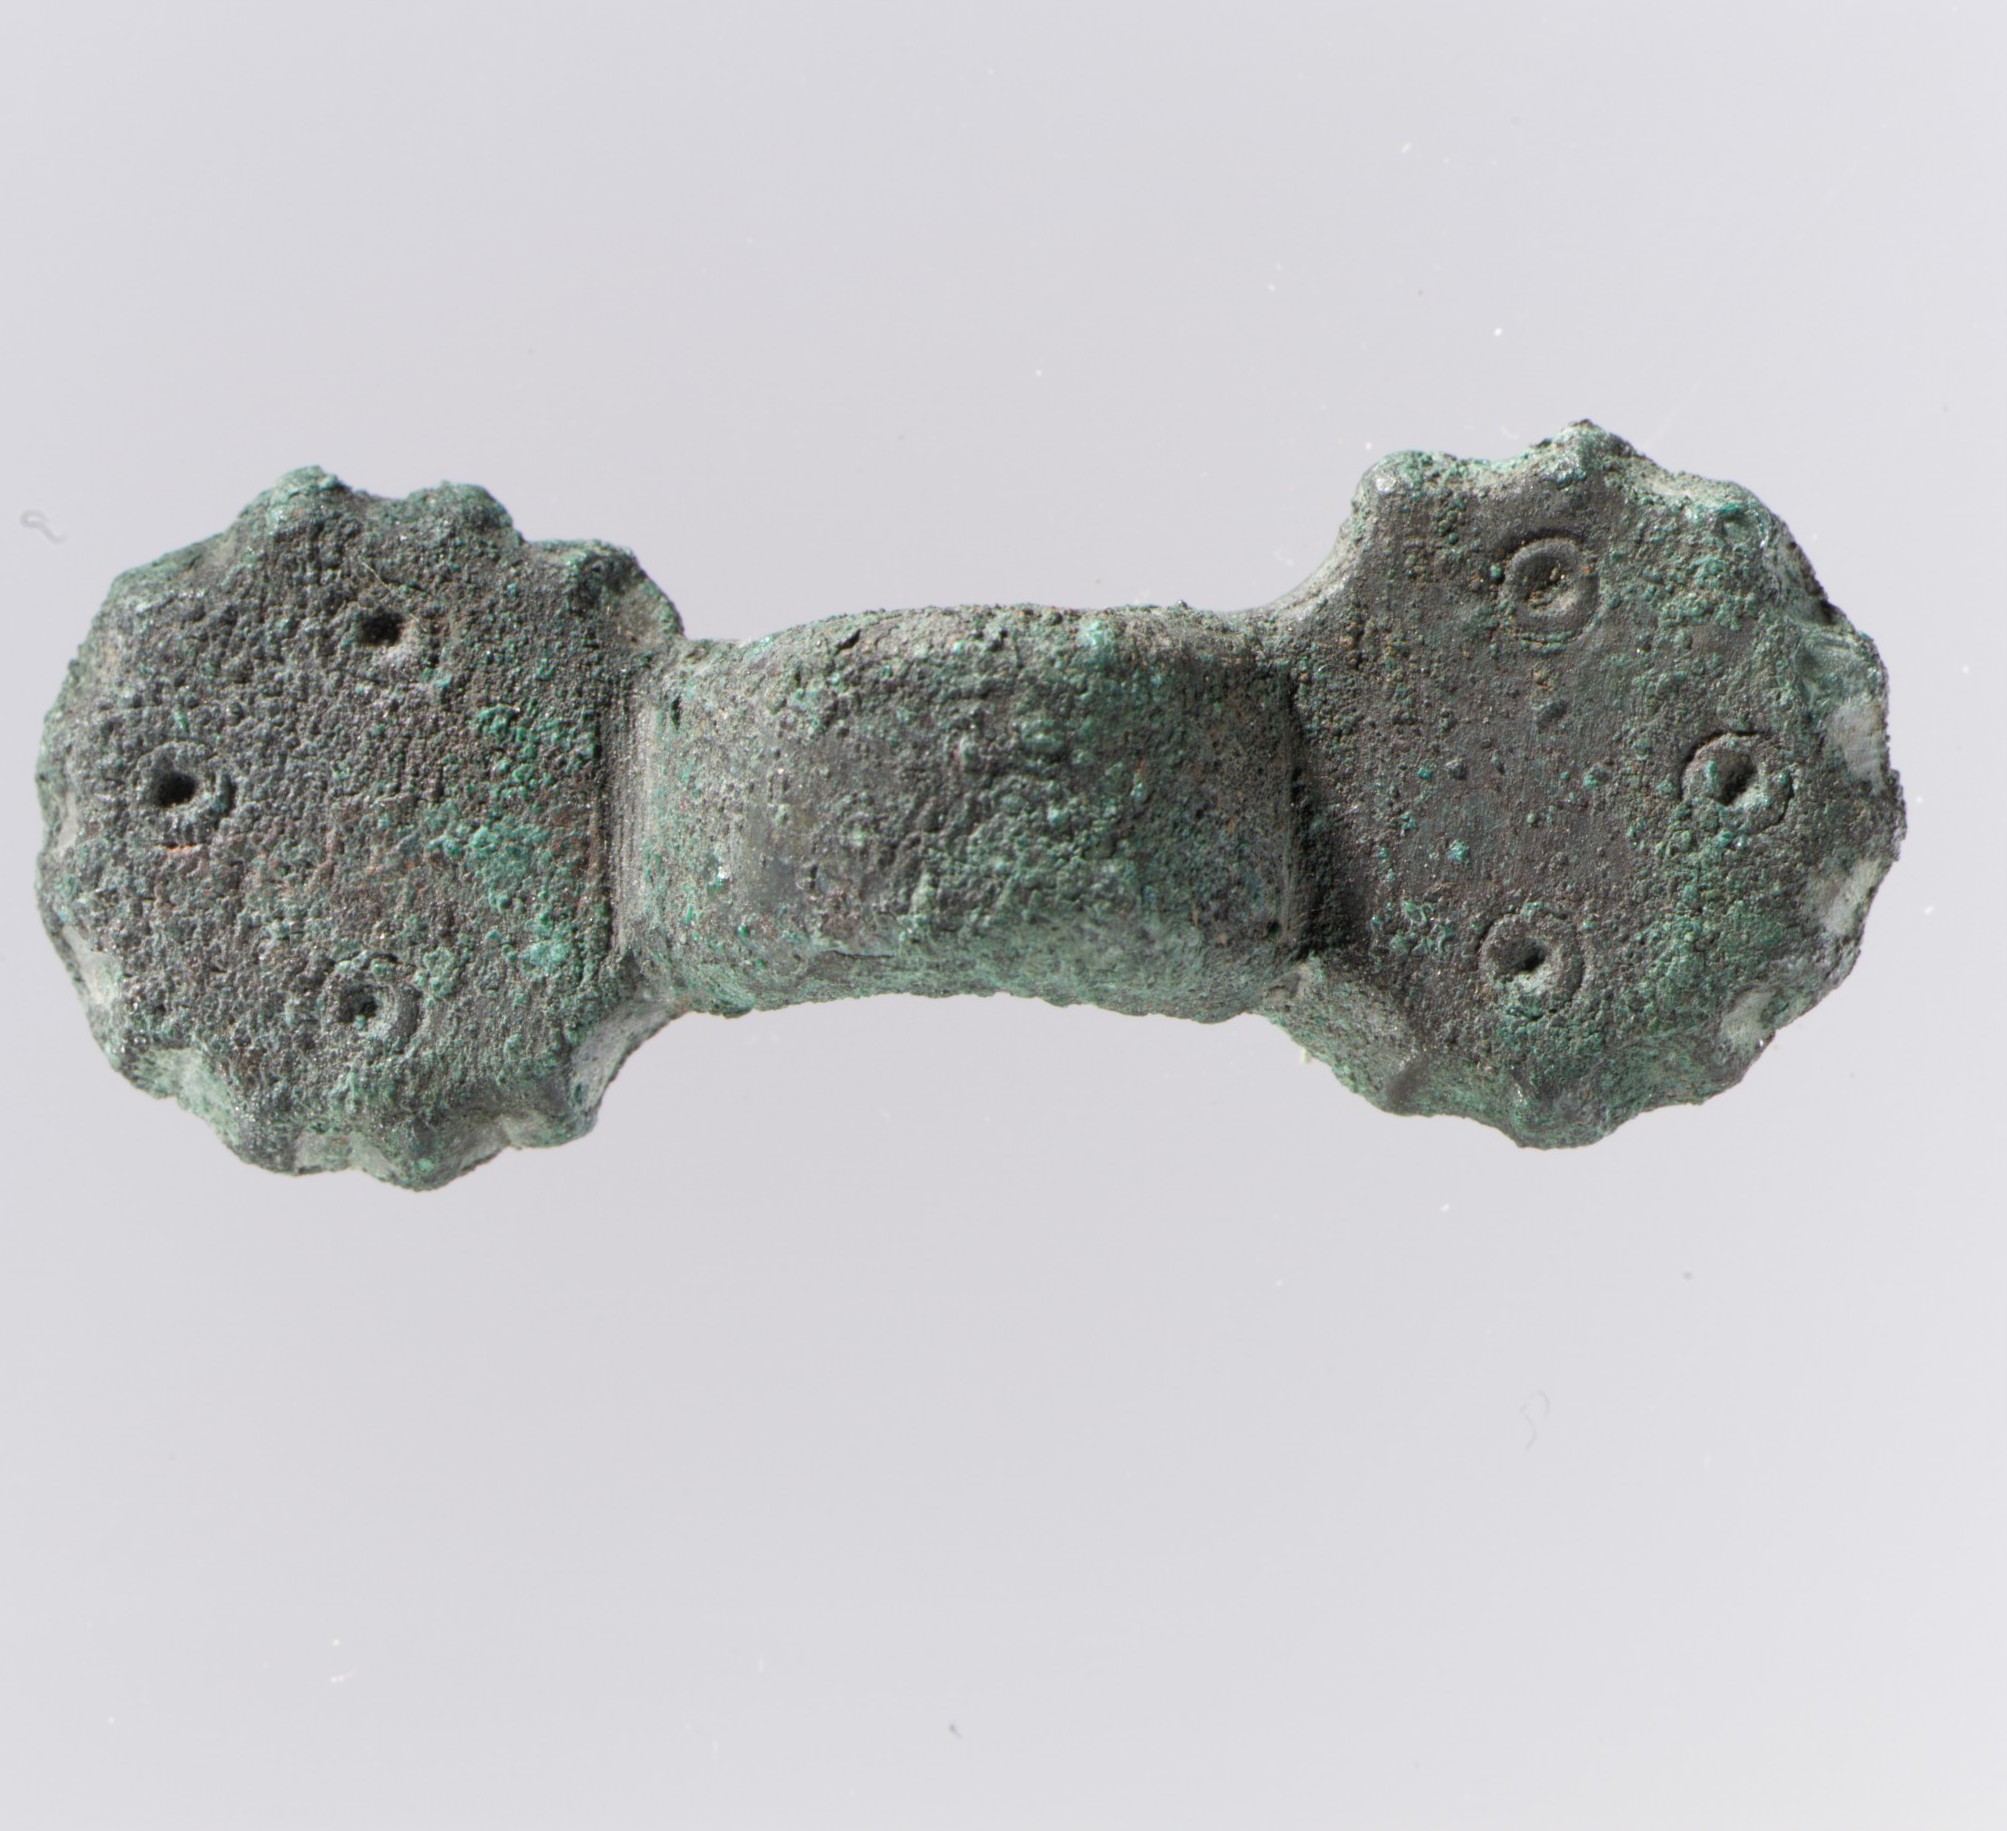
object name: brooch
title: Equal-Arm Brooch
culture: frankish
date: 650-750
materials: copper alloy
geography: germany